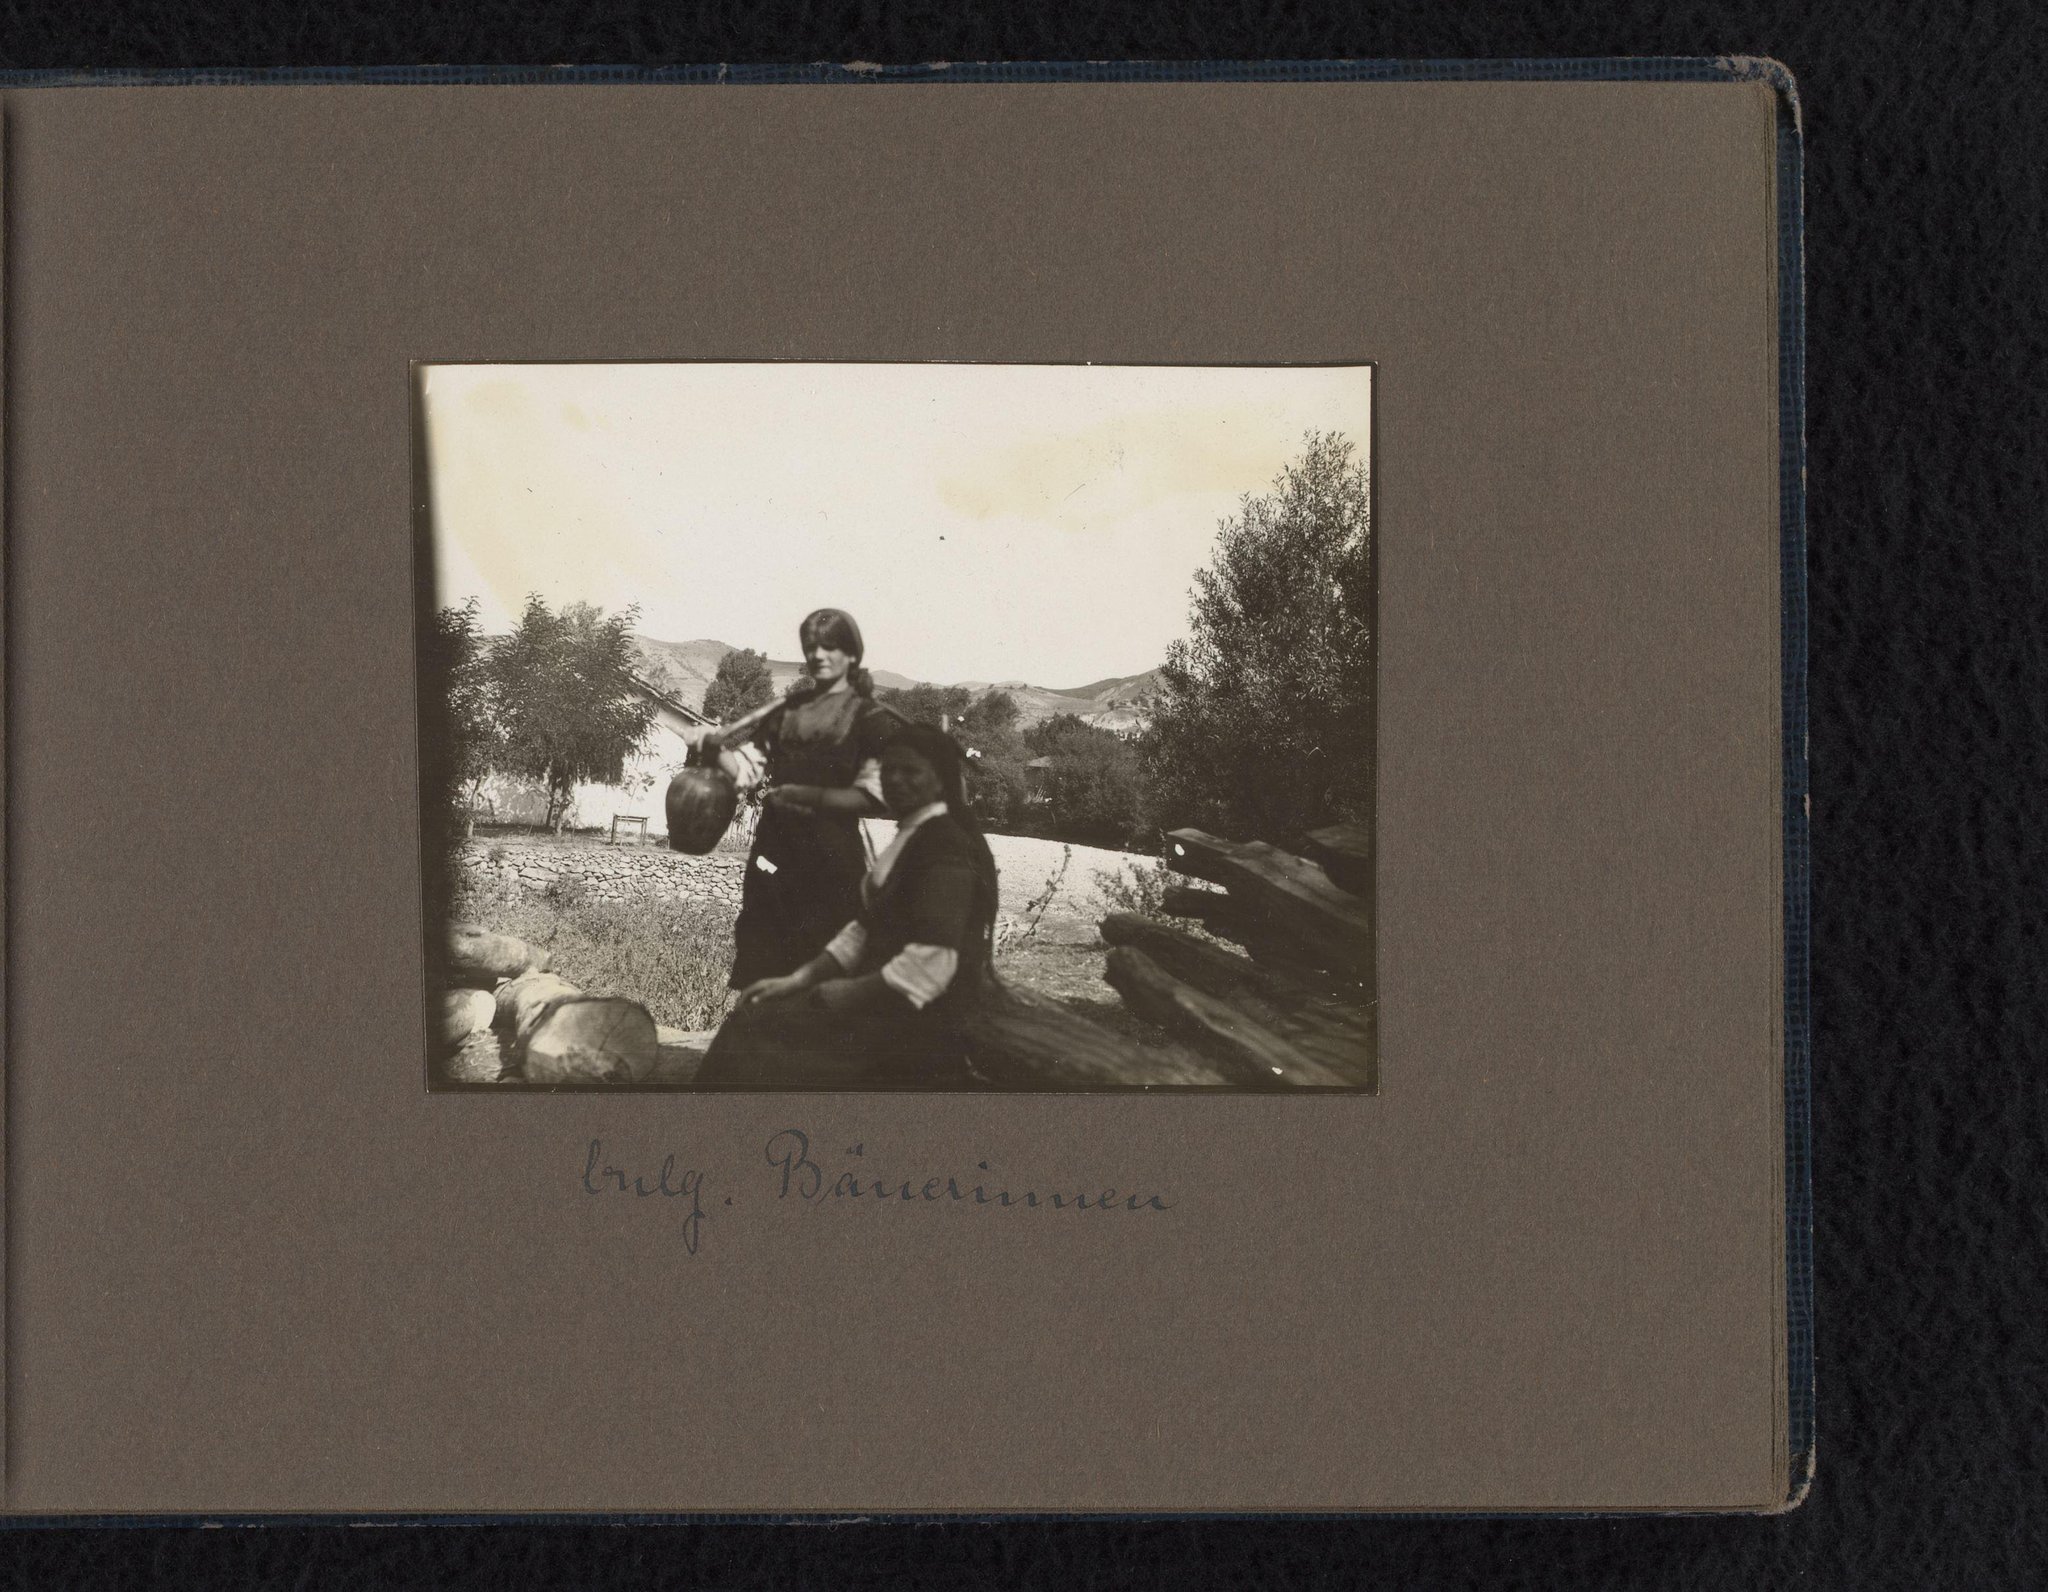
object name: album leaf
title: Bulgaarse boerinnen in een Bulgaars dorp, tijdens een rondreis van Eugen Wachenheimer en zijn echtgenote Else Wachenheimer-Moos door Bulgarije, 1922-1923, (mogelijk omgeving Sofia)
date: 1922-1923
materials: paper, photographic support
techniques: gelatin silver print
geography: bulgaria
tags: village (+ city(-scape) with figures, staffage)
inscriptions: inscription: ‘bulg. Bäuerinnen’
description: Albumblad bevat een foto van twee Bulgaarse boerinnen. Uit album half formaat, blauw kunstlederen omslag met koordbinding.